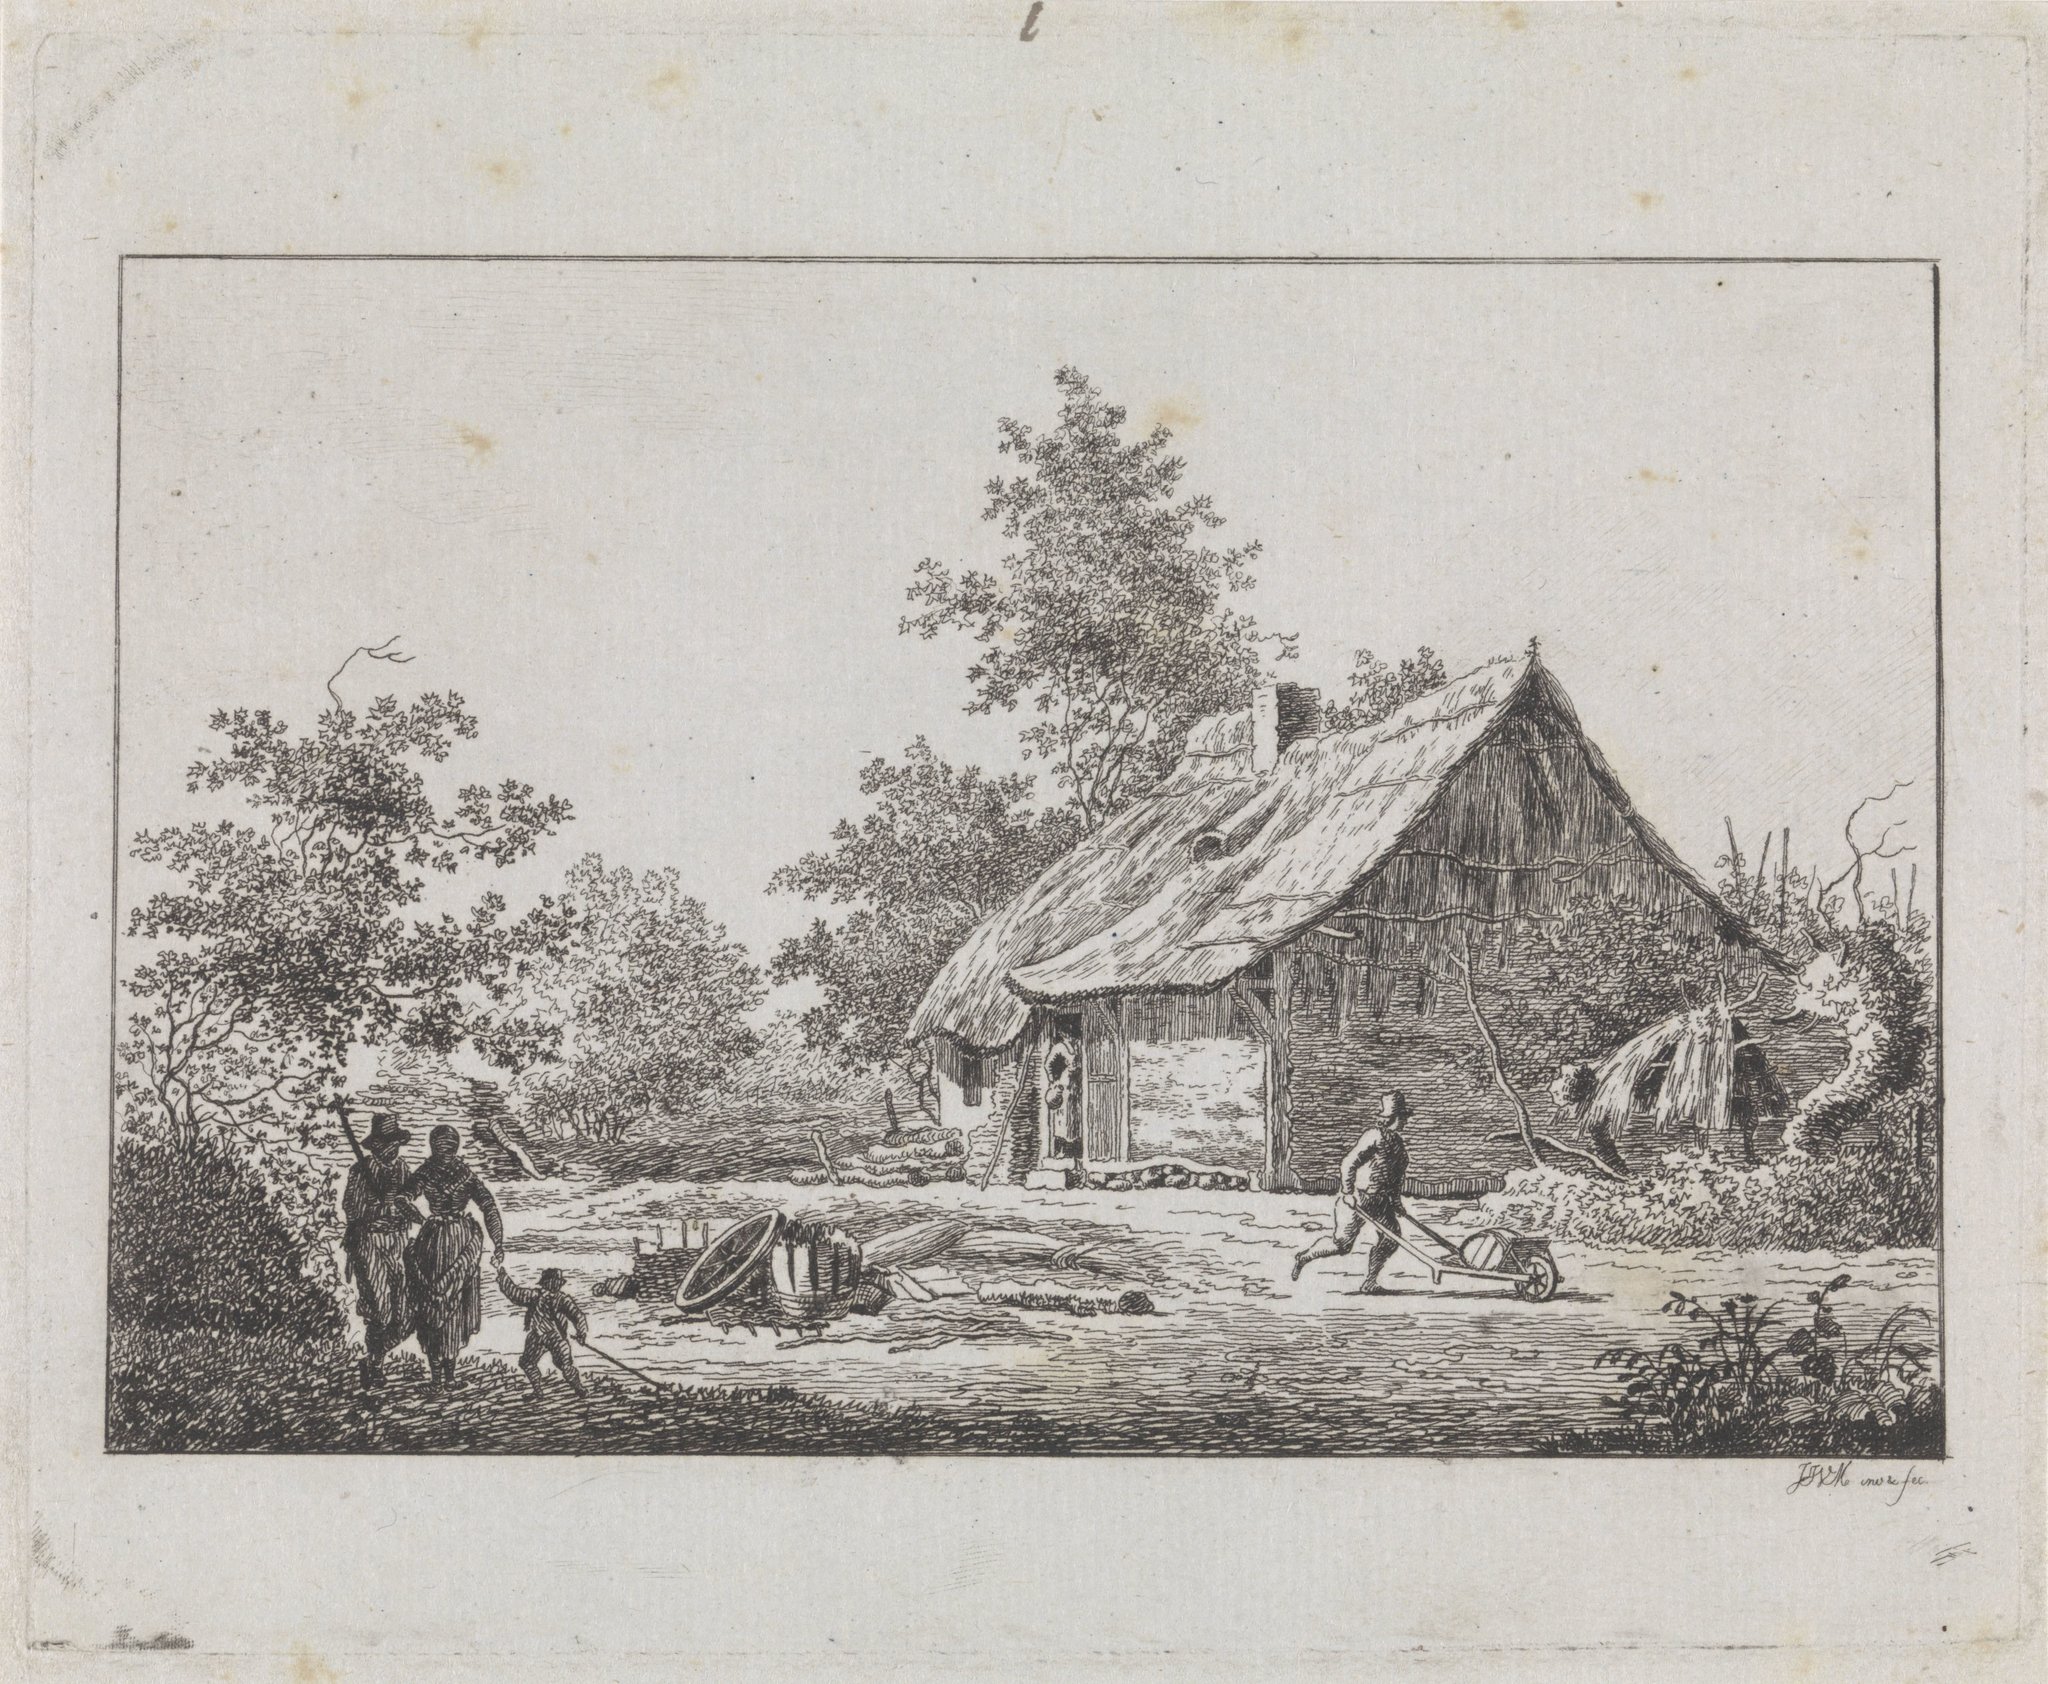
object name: print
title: Figuren bij een boerderij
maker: jan izaak van mansvelt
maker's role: print maker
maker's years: 1761-1802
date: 1771-1802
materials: paper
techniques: etching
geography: netherlands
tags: wheelbarrow, landscapes (+ landscape with figures, staffage), farm or solitary house in landscape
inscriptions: collector's mark: Lugt 2228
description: Paar met kind en een man met een kruiwagen bij een boerderij.